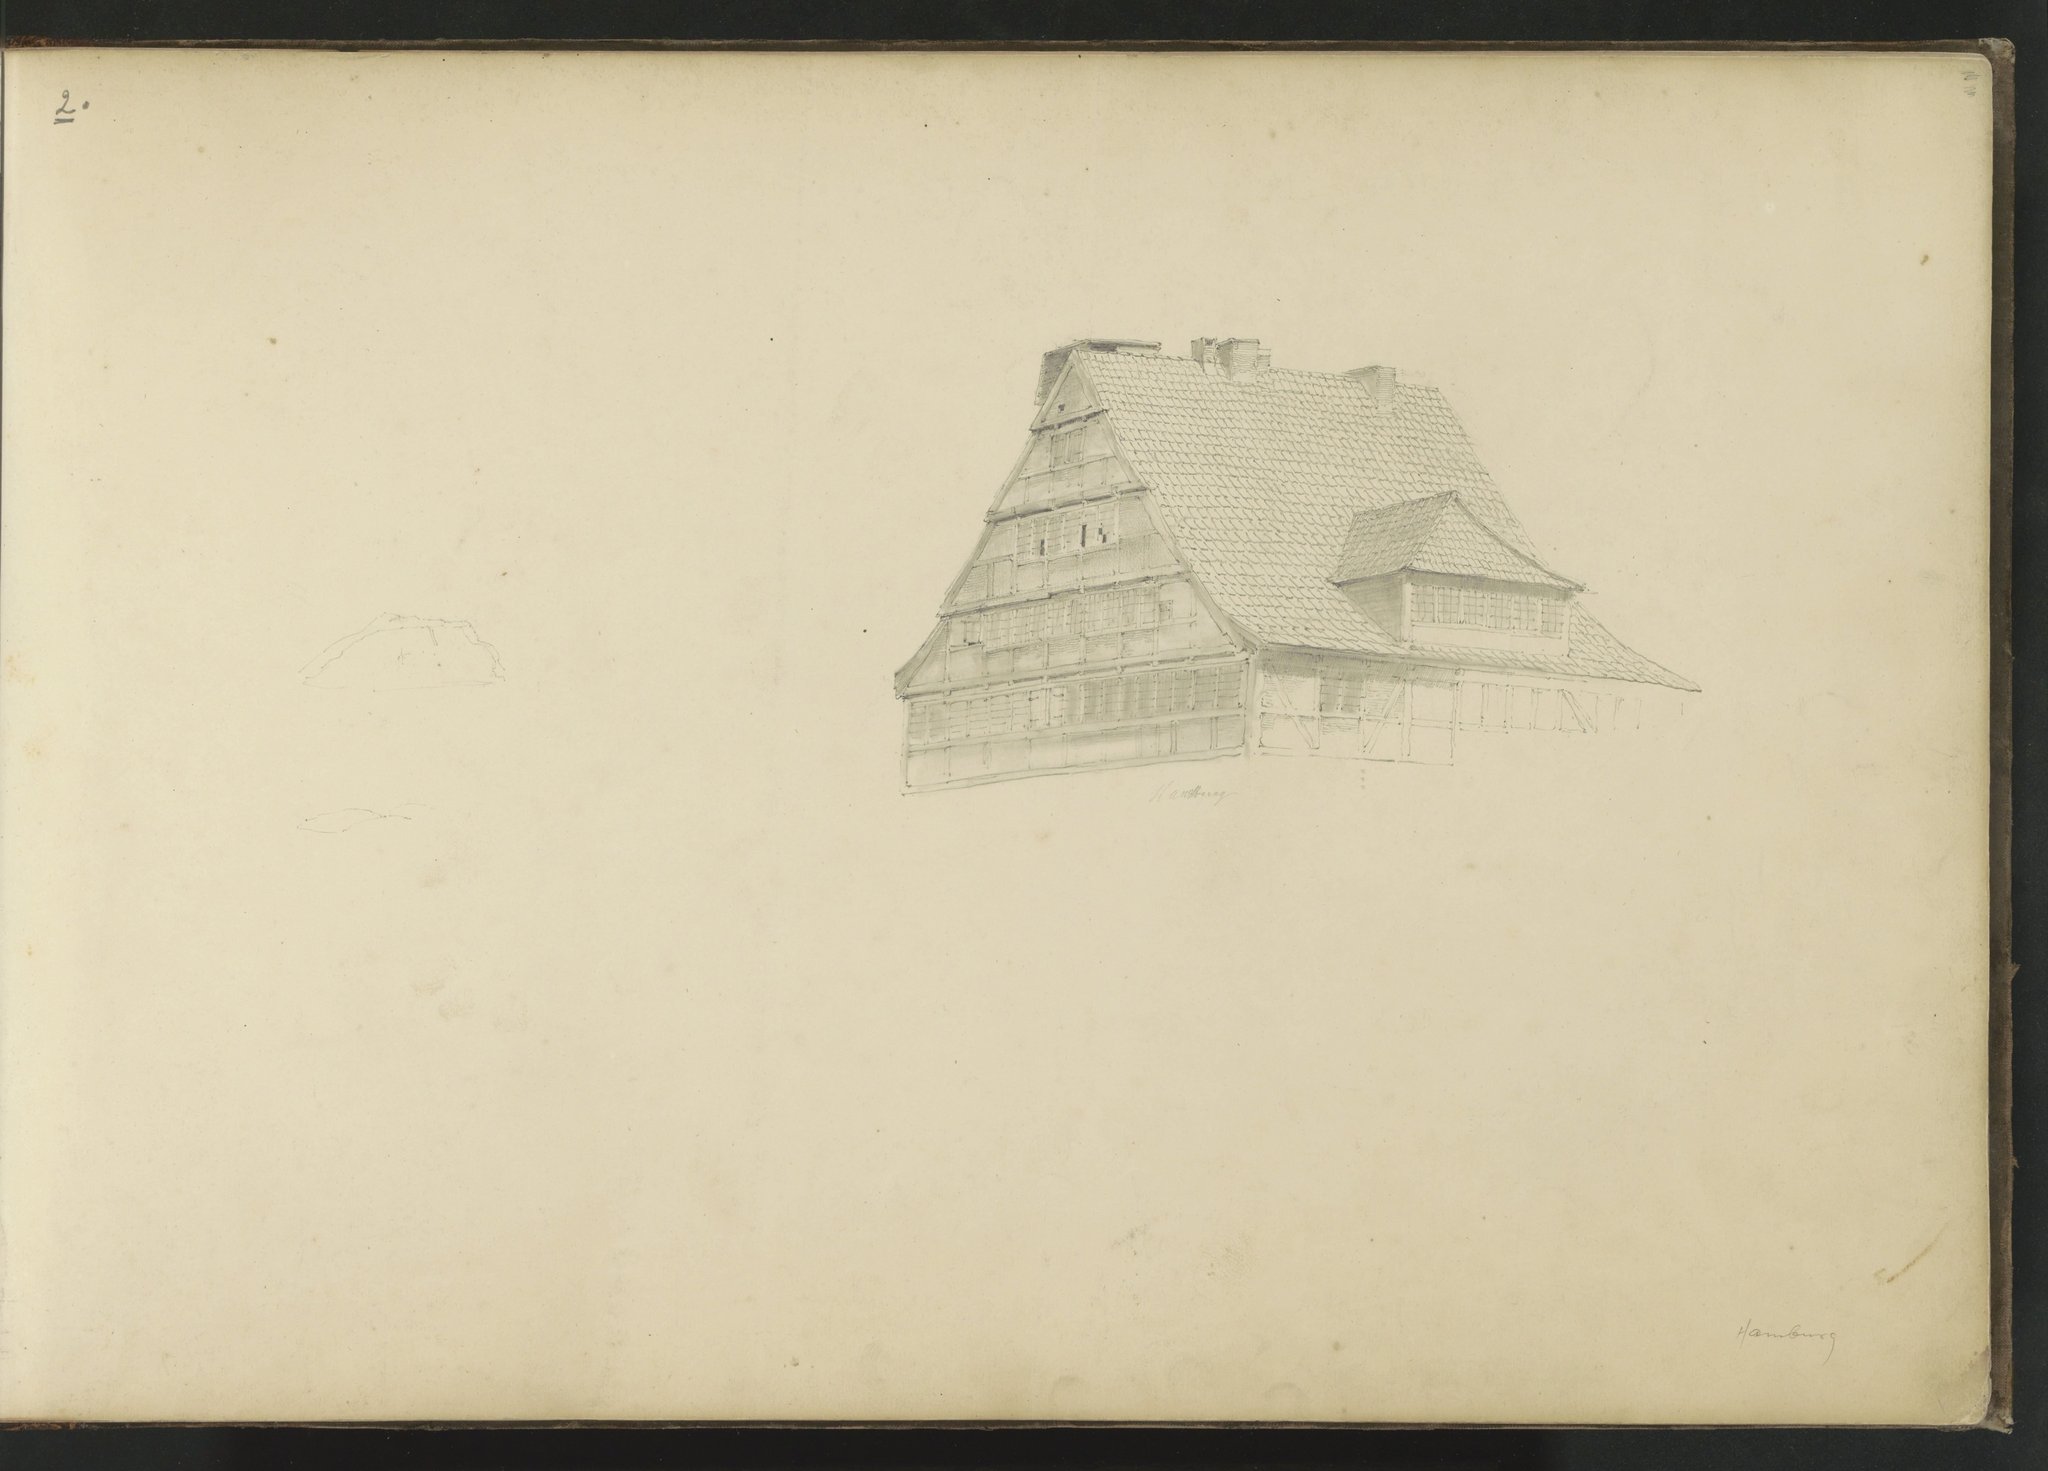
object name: sketchbook leaf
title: Vakwerkhuis te Hamburg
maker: kasparus karsen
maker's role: draughtsman, painter, print maker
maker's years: 1810-1896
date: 1820-1896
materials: paper, pencil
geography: hamburg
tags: the usual house or row of houses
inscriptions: annotation: ‘Hamburg/ Hamburg’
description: Blad 2 recto uit een schetsboek met 68 bladen.